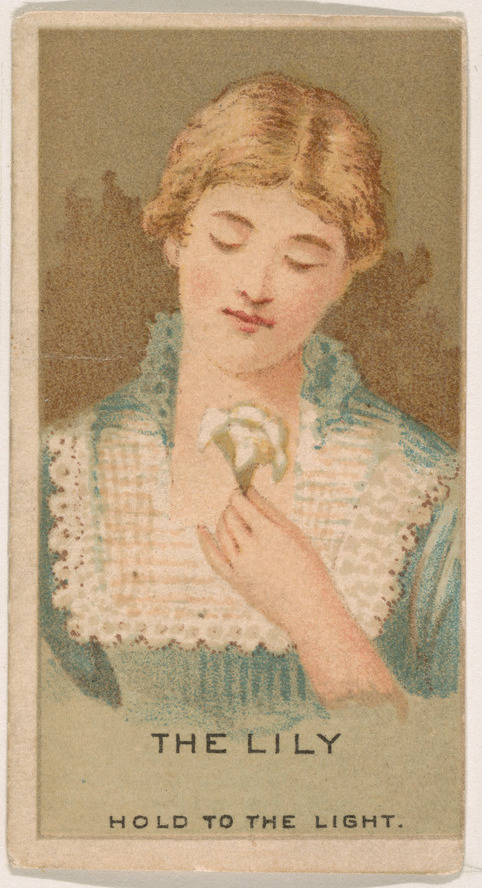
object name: print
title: The Lily, from the Magic Changing Cards series (N223) issued by Kinney Tobacco Company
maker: kinney brothers tobacco company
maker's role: publisher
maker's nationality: american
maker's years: 1869-2011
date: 1889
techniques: color lithograph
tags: women,lilies